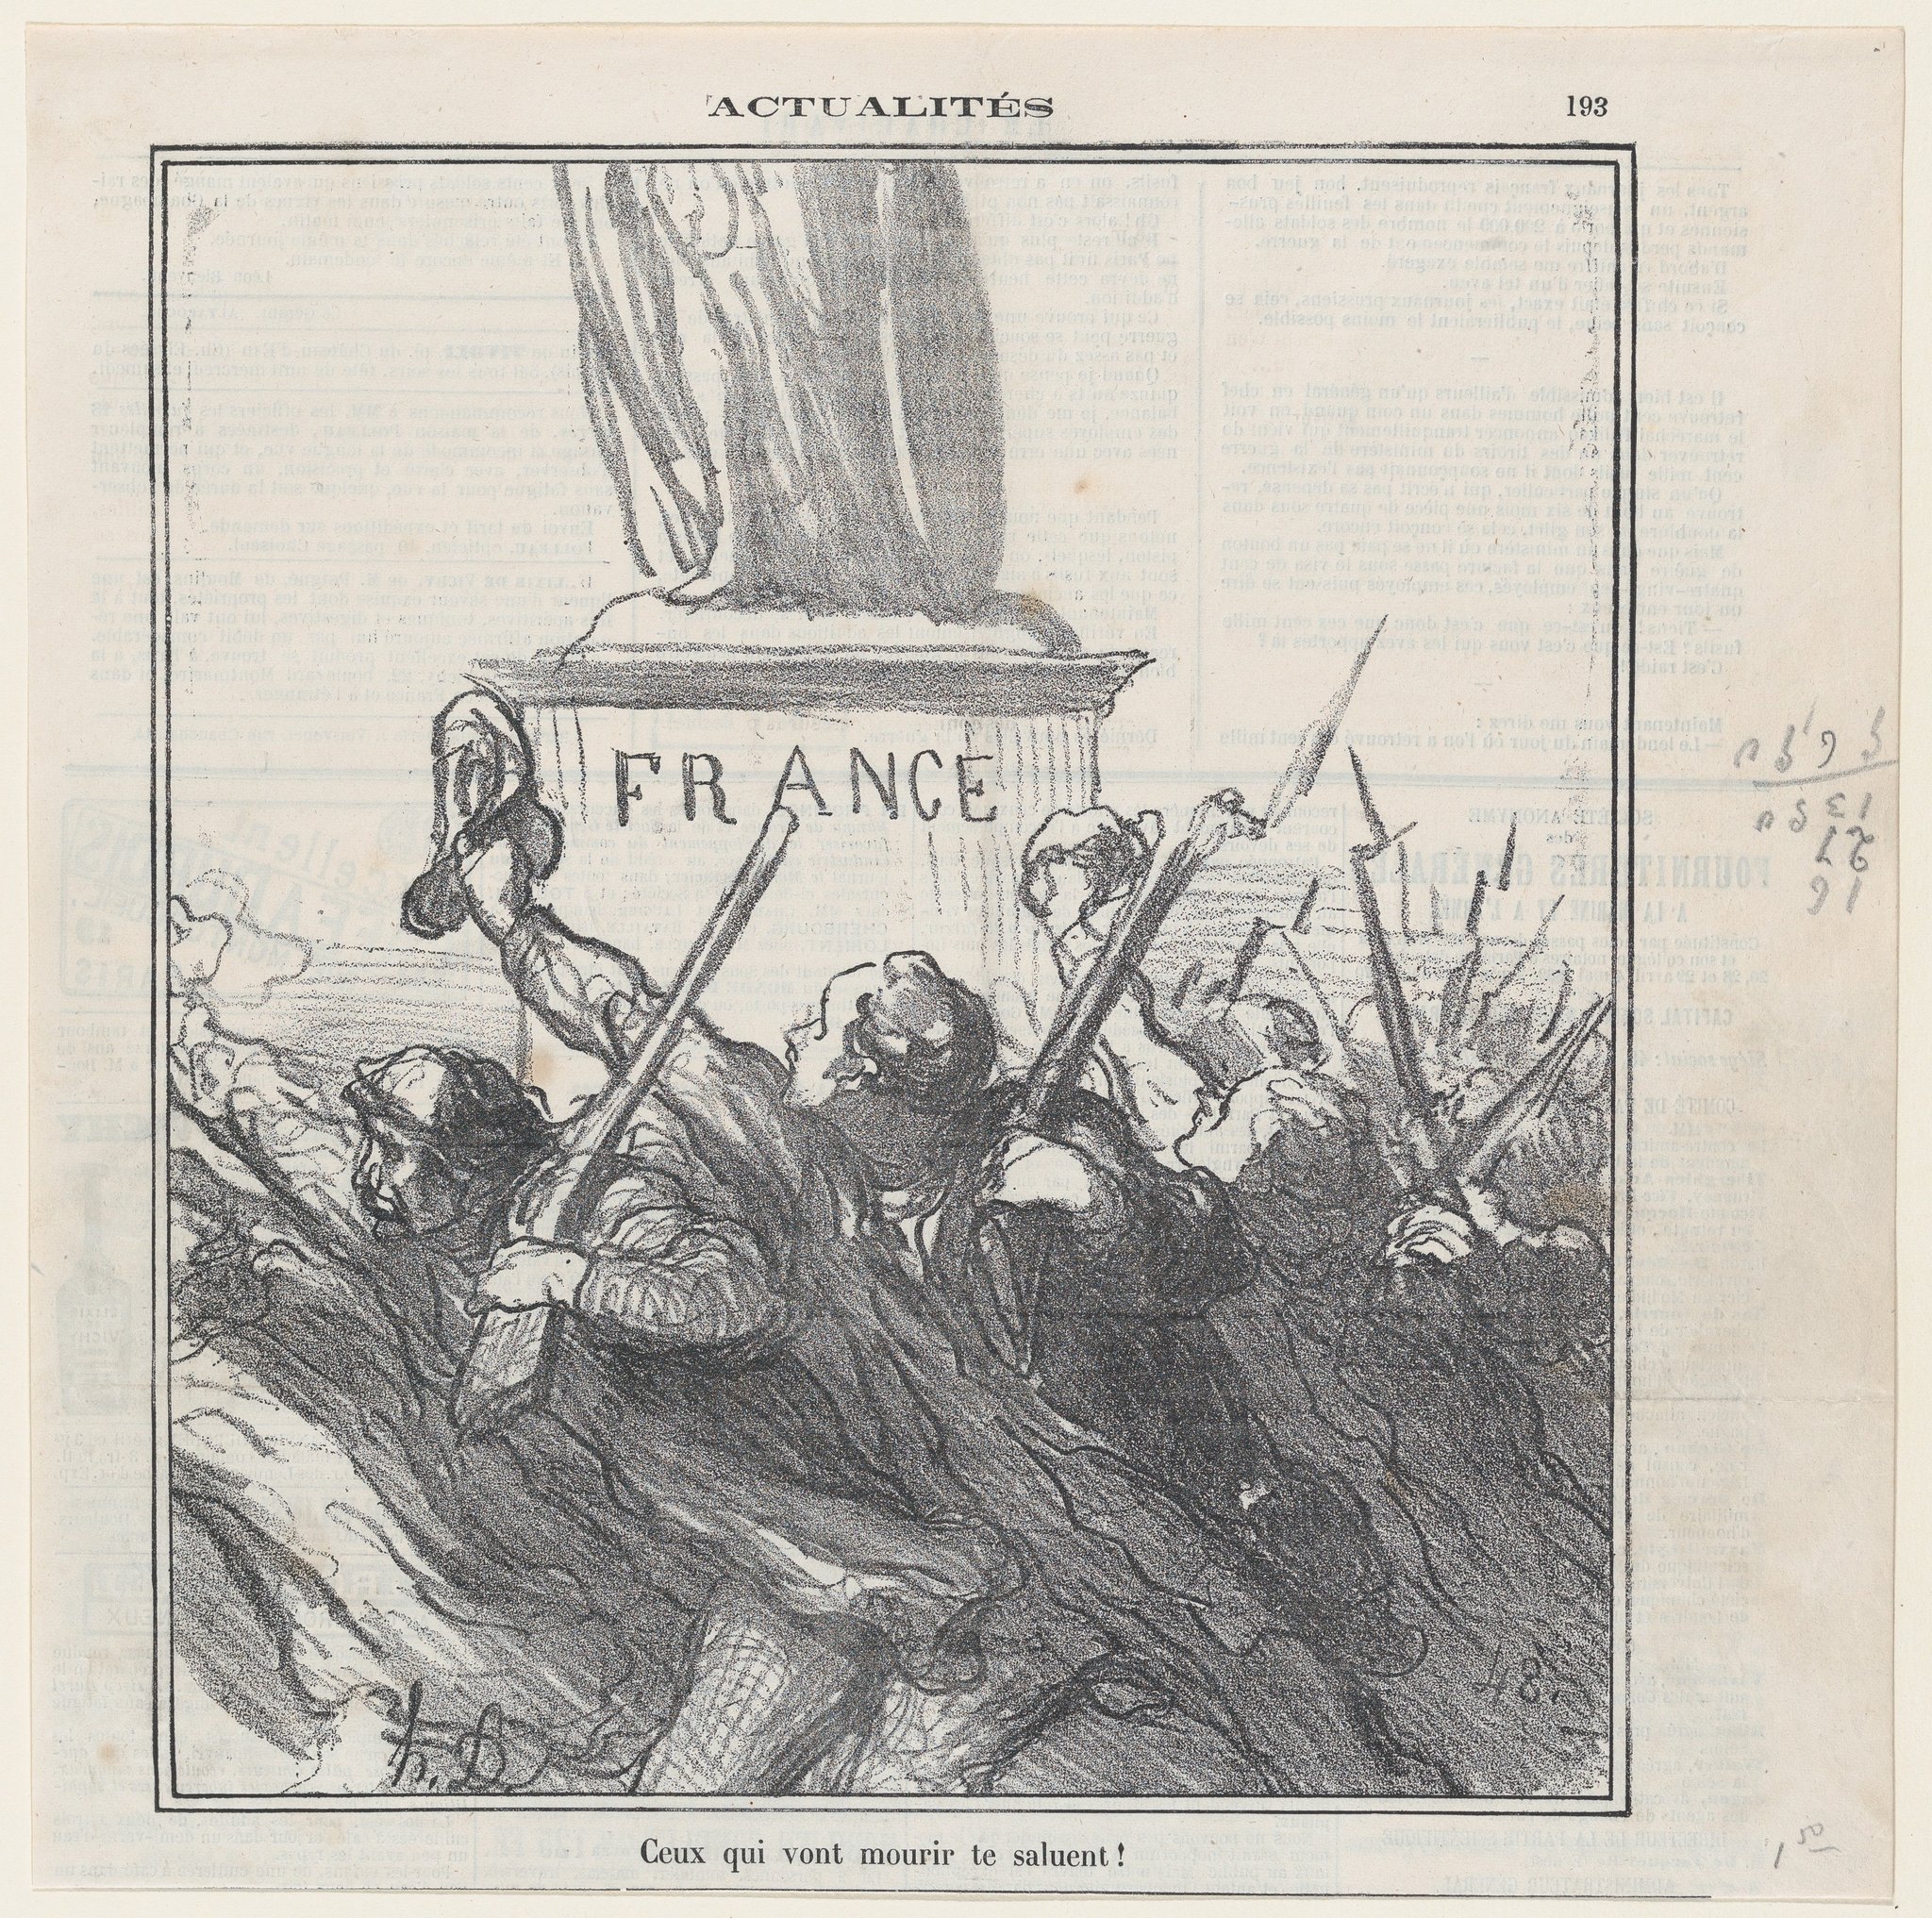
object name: print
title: Those who are about to die, salute thee, from "News of the day"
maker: honoré daumier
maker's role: artist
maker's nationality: french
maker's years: 1808-1879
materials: paper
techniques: lithograph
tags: firearms,men,crowd